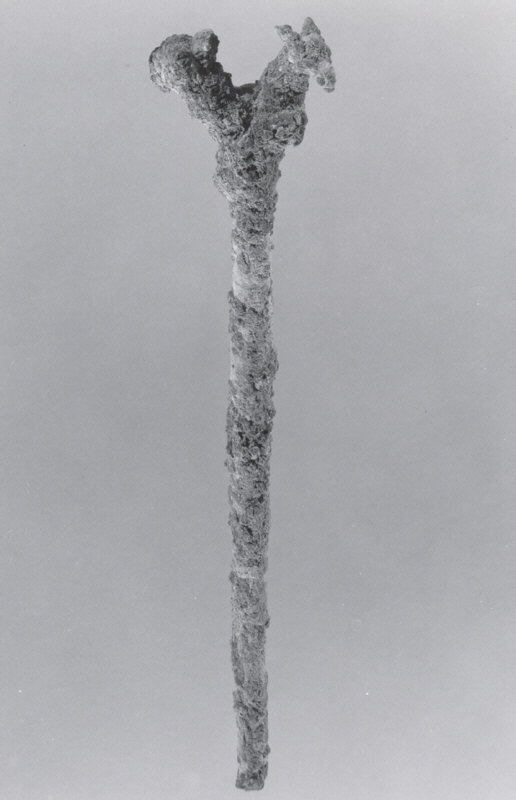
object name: pin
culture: bactria-margiana archaeological complex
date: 2333-1668 BCE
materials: copper alloy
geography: bactria-margiana